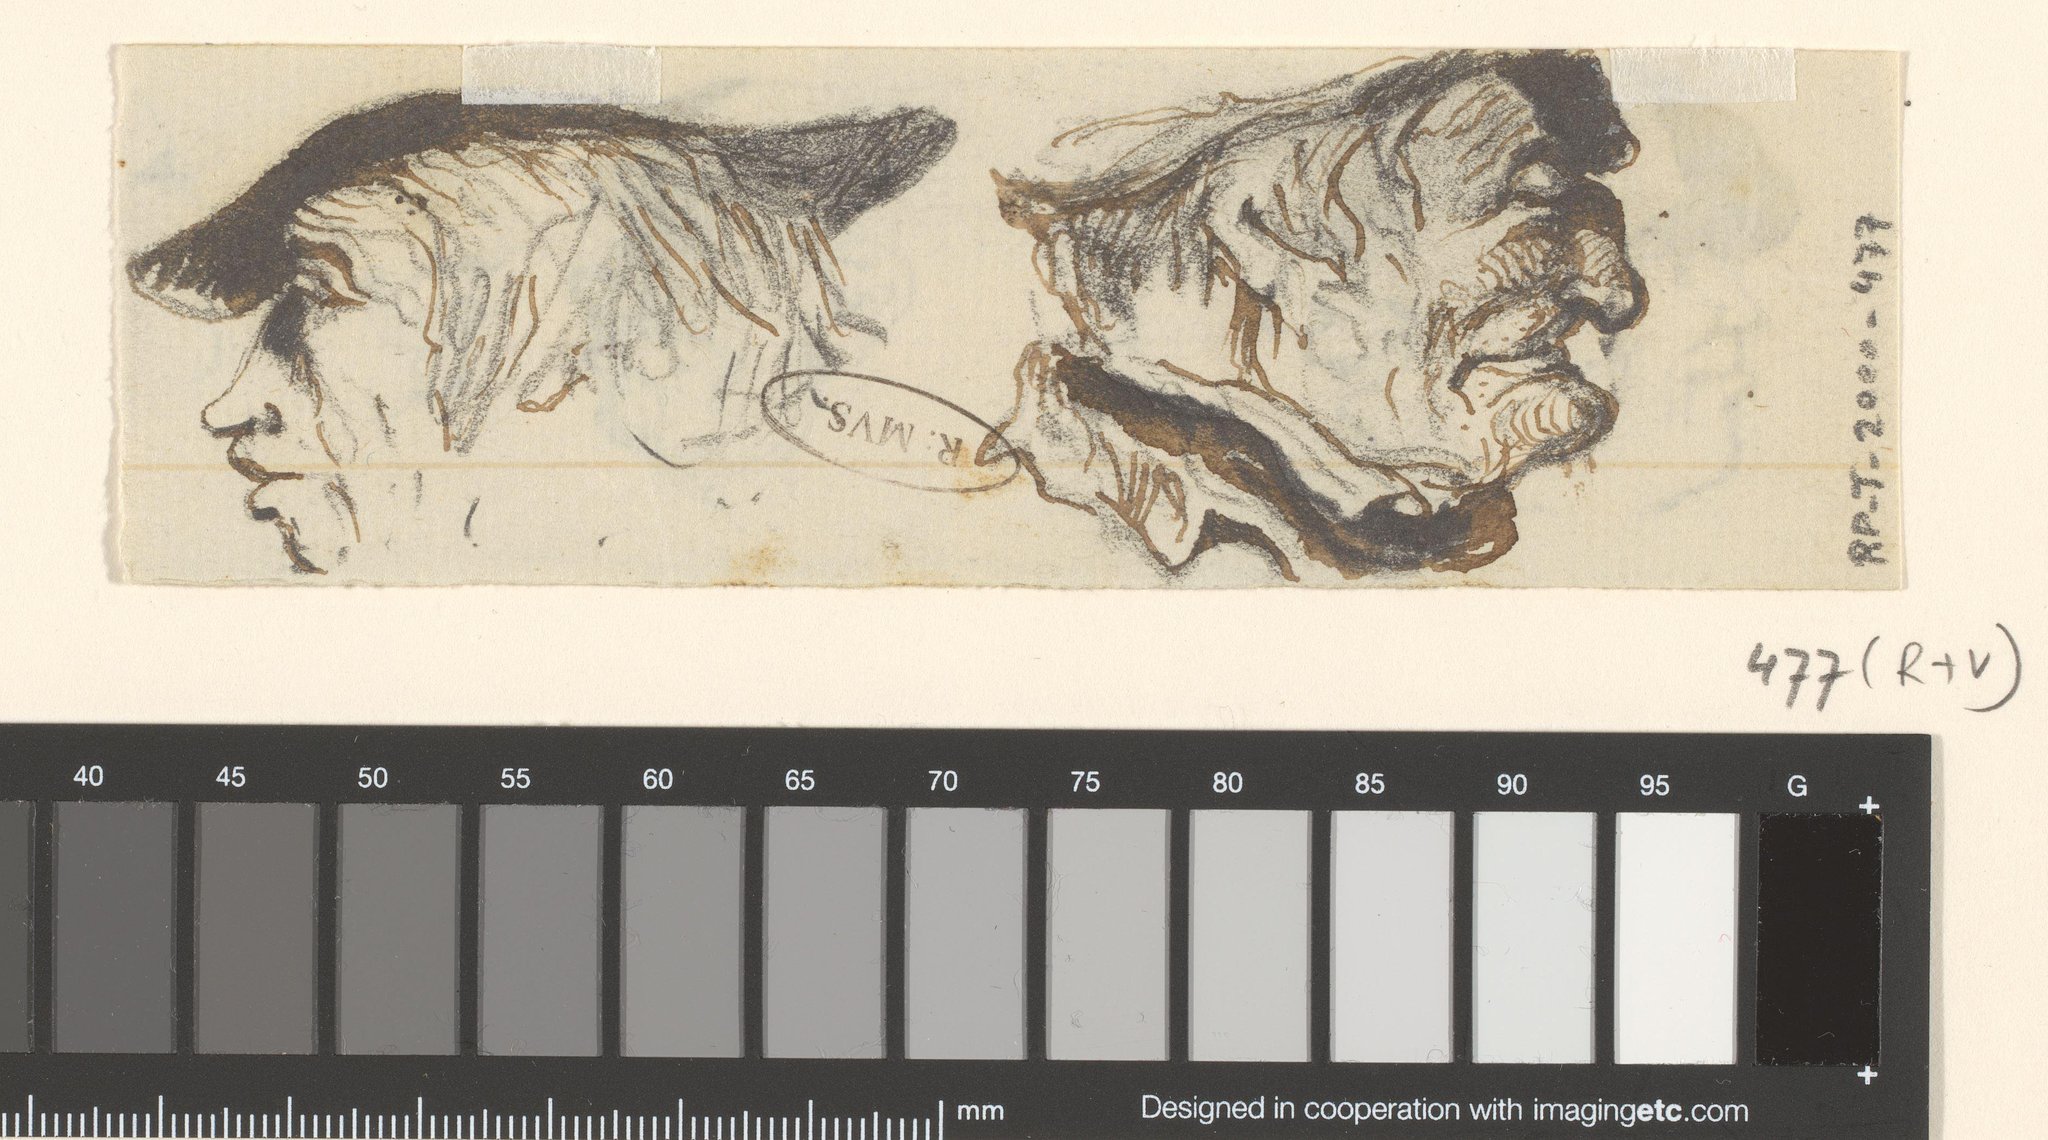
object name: drawing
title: Twee koppen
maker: johannes tavenraat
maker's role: draughtsman, painter, print maker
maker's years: 1809-1881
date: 1840-1880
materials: ink, paper, pencil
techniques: pen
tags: caricatures (human types)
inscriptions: collector's mark: Lugt 2228